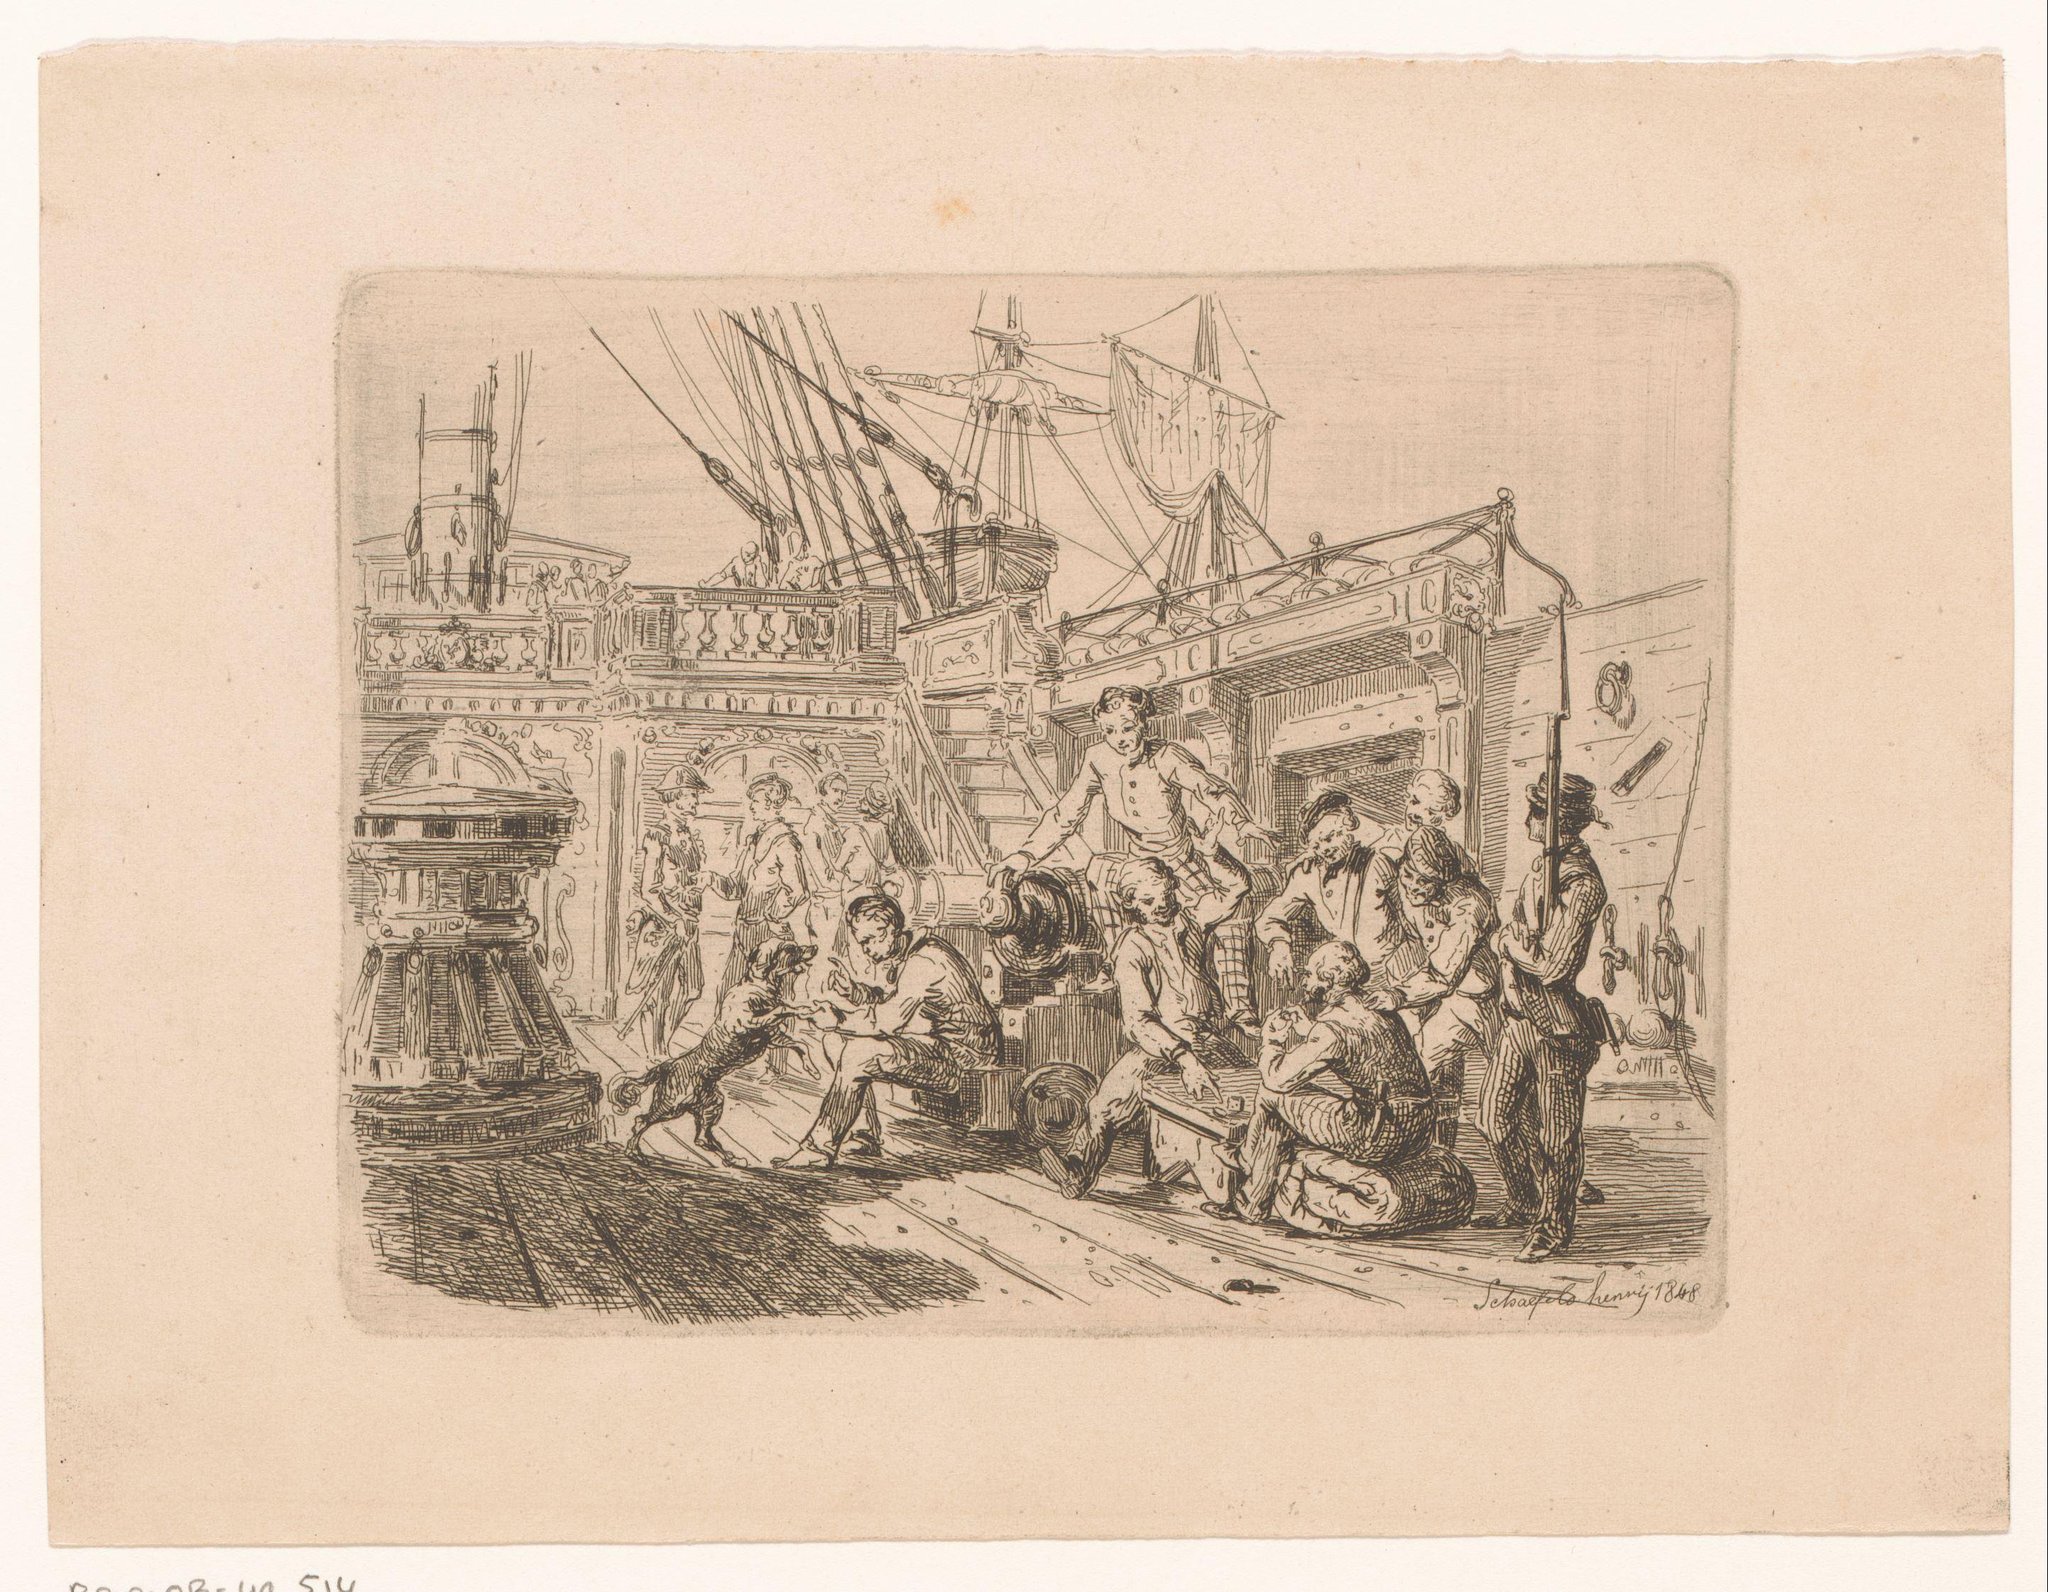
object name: print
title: Scheepsbemanning dobbelt op het dek van een schip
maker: henri françois schaefels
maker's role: print maker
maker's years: 1827-1904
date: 1848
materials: paper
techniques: etching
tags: crew ~ ship, dice-games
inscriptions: collector's mark: Lugt 2228